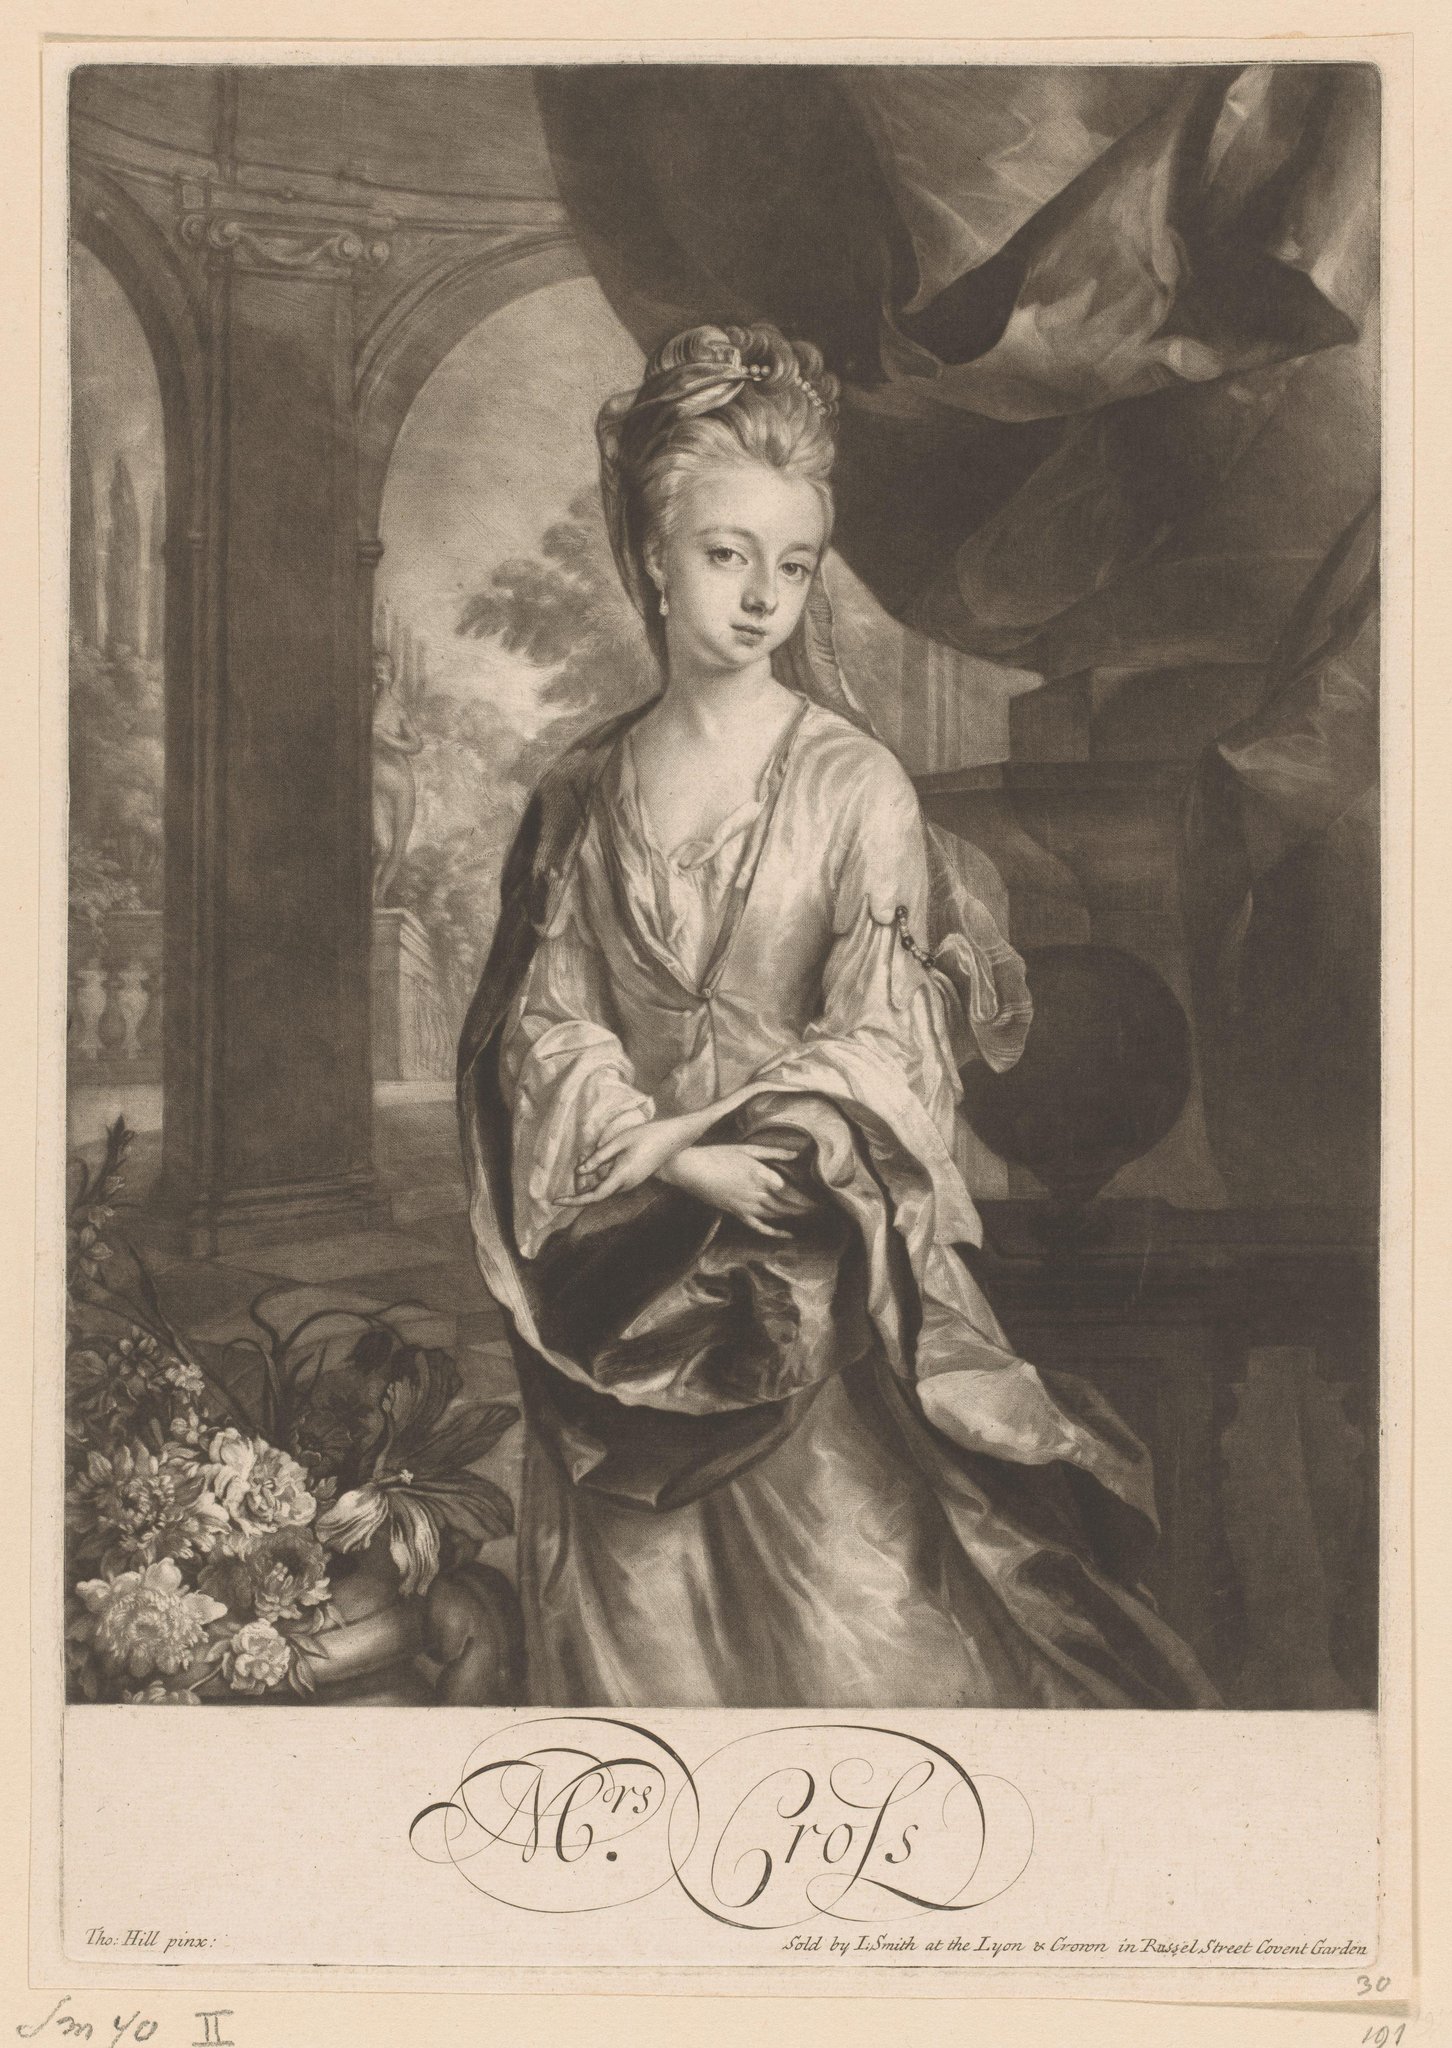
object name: print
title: Portret van mevrouw Cross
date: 1697-1742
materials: paper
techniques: mezzotint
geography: london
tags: historical persons, actor, actress (non-work situations)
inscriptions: collector's mark: Lugt 240